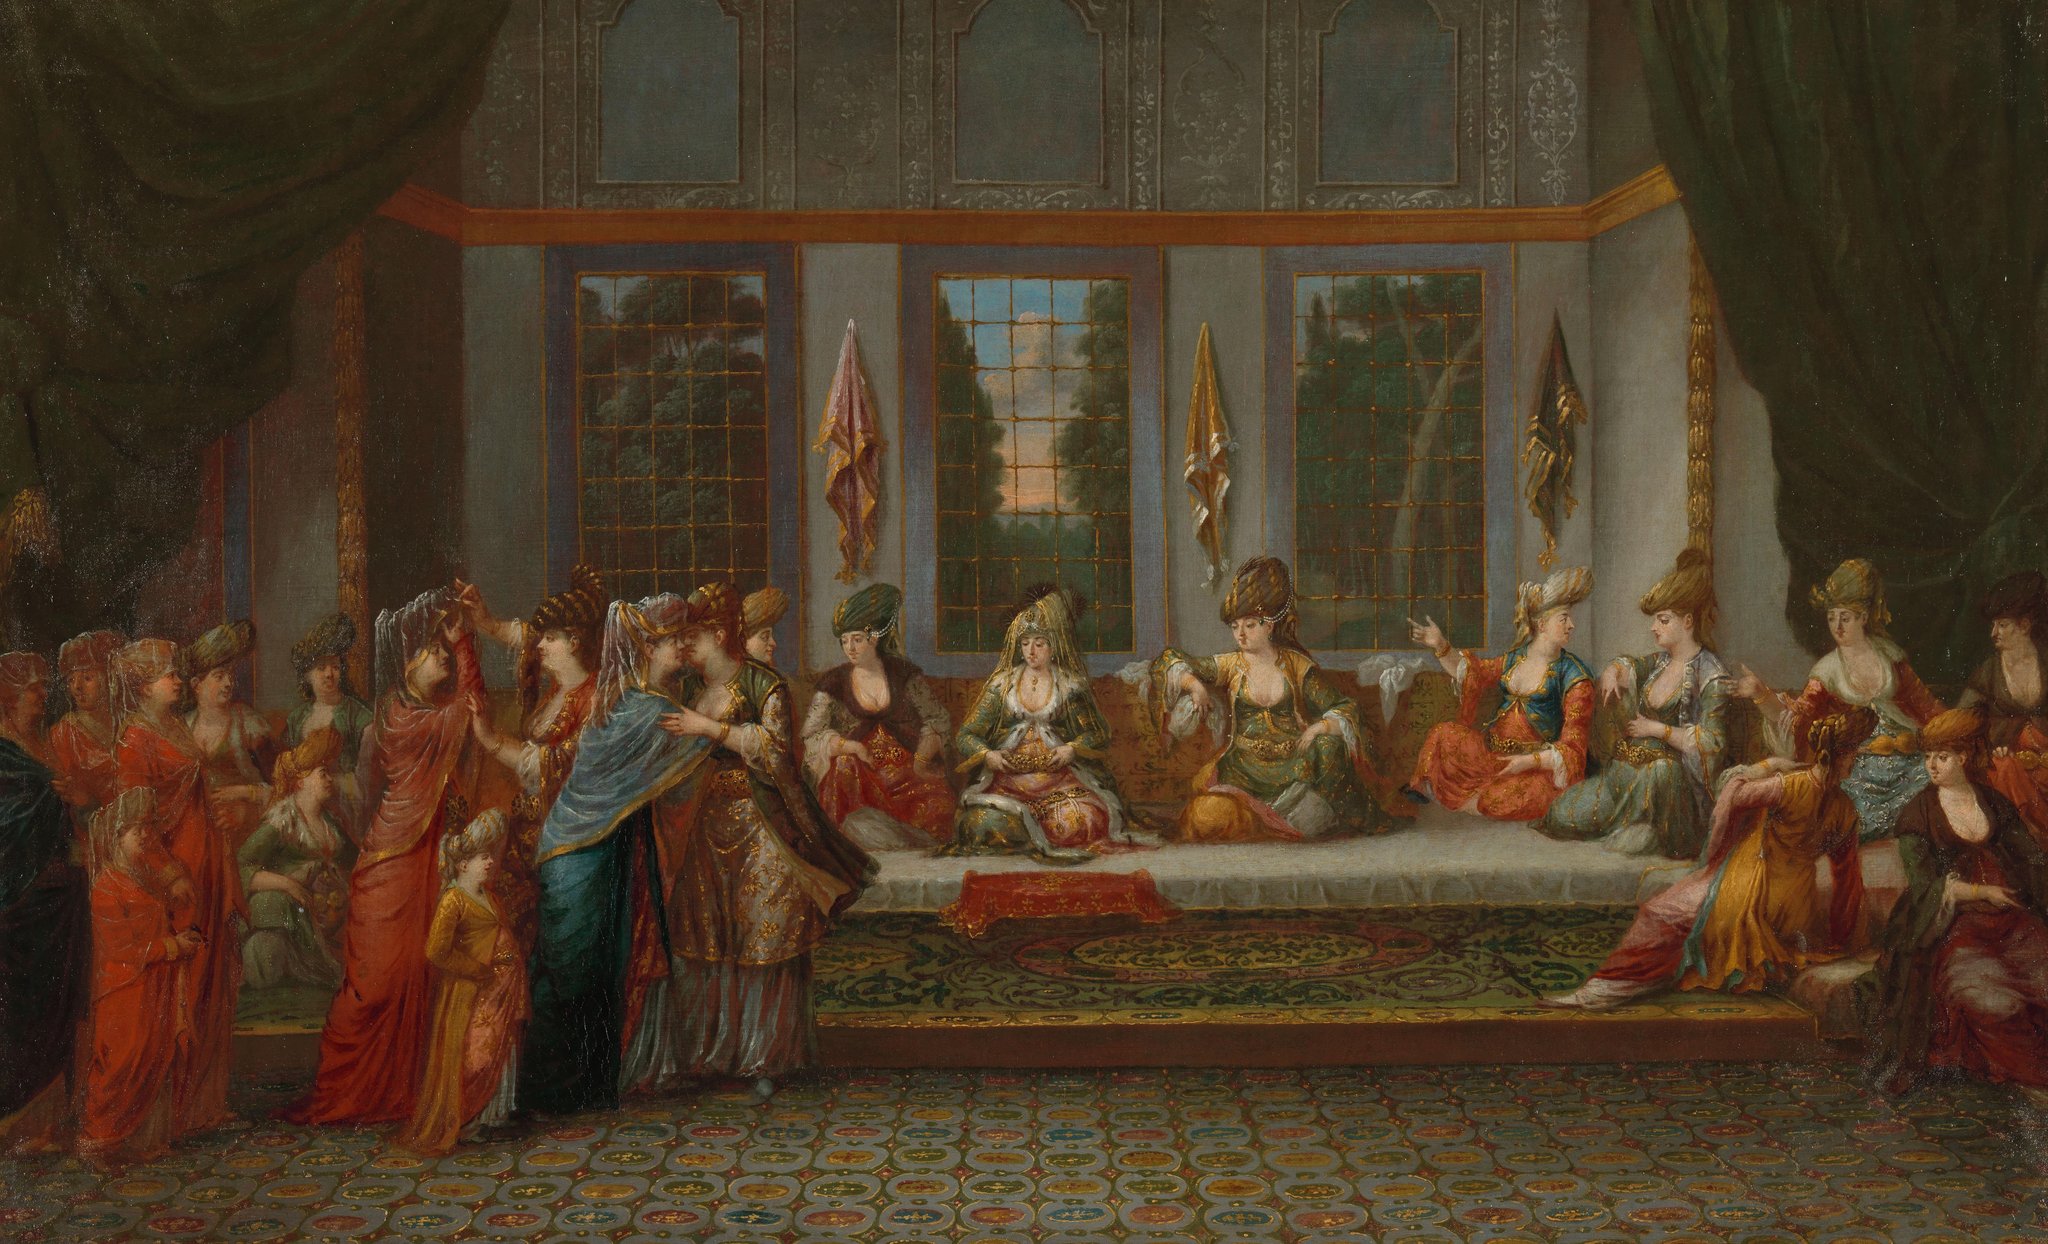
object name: painting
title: Greek Wedding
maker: jean baptiste vanmour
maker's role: painter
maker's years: 1671-1737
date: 1720-1737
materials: canvas, oil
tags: saluting, bride (in wedding-dress)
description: A Greek bride sits on a low platform, surrounded by family and friends. Her mother and mother-in-law welcome visitors. The bride receives gifts of gold jewellery and sumptuous cloth from her guests. In keeping with sumptuary laws (dress codes), the women do not wear veils inside the house. It is impossible to distinguish between the Greek and Turkish women based on their indoor attire.